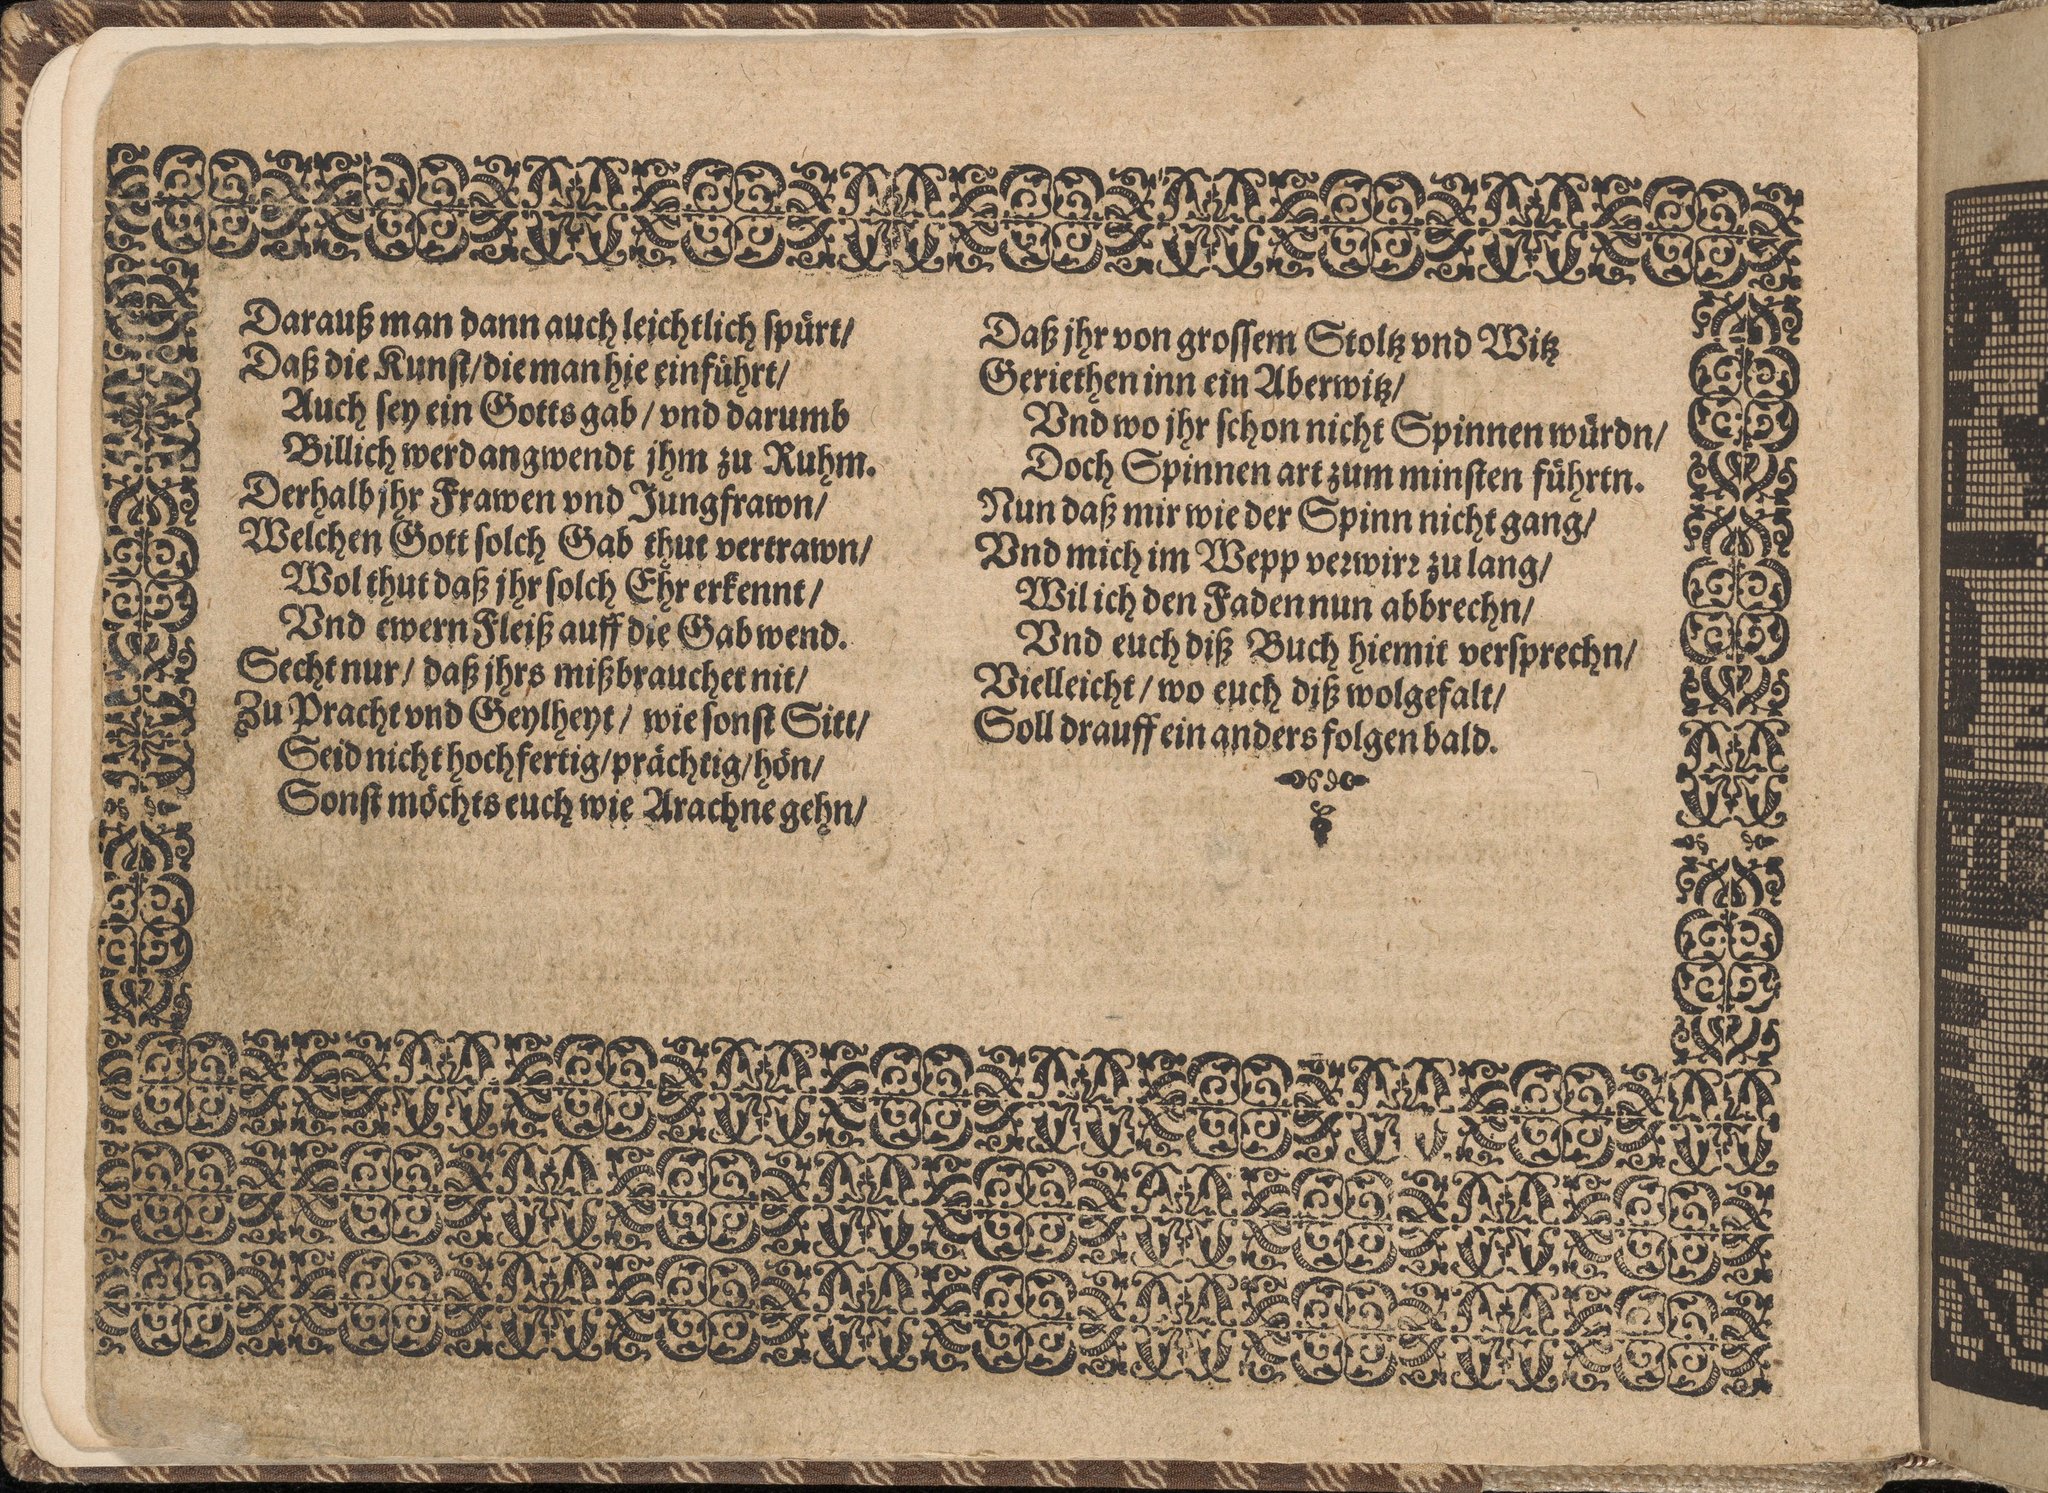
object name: book print ornament architecture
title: New Künstlichs Modelbuch (Page 2 verso)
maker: bernhard jobin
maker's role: publisher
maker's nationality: swiss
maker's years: 1535-1597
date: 1600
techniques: woodcut